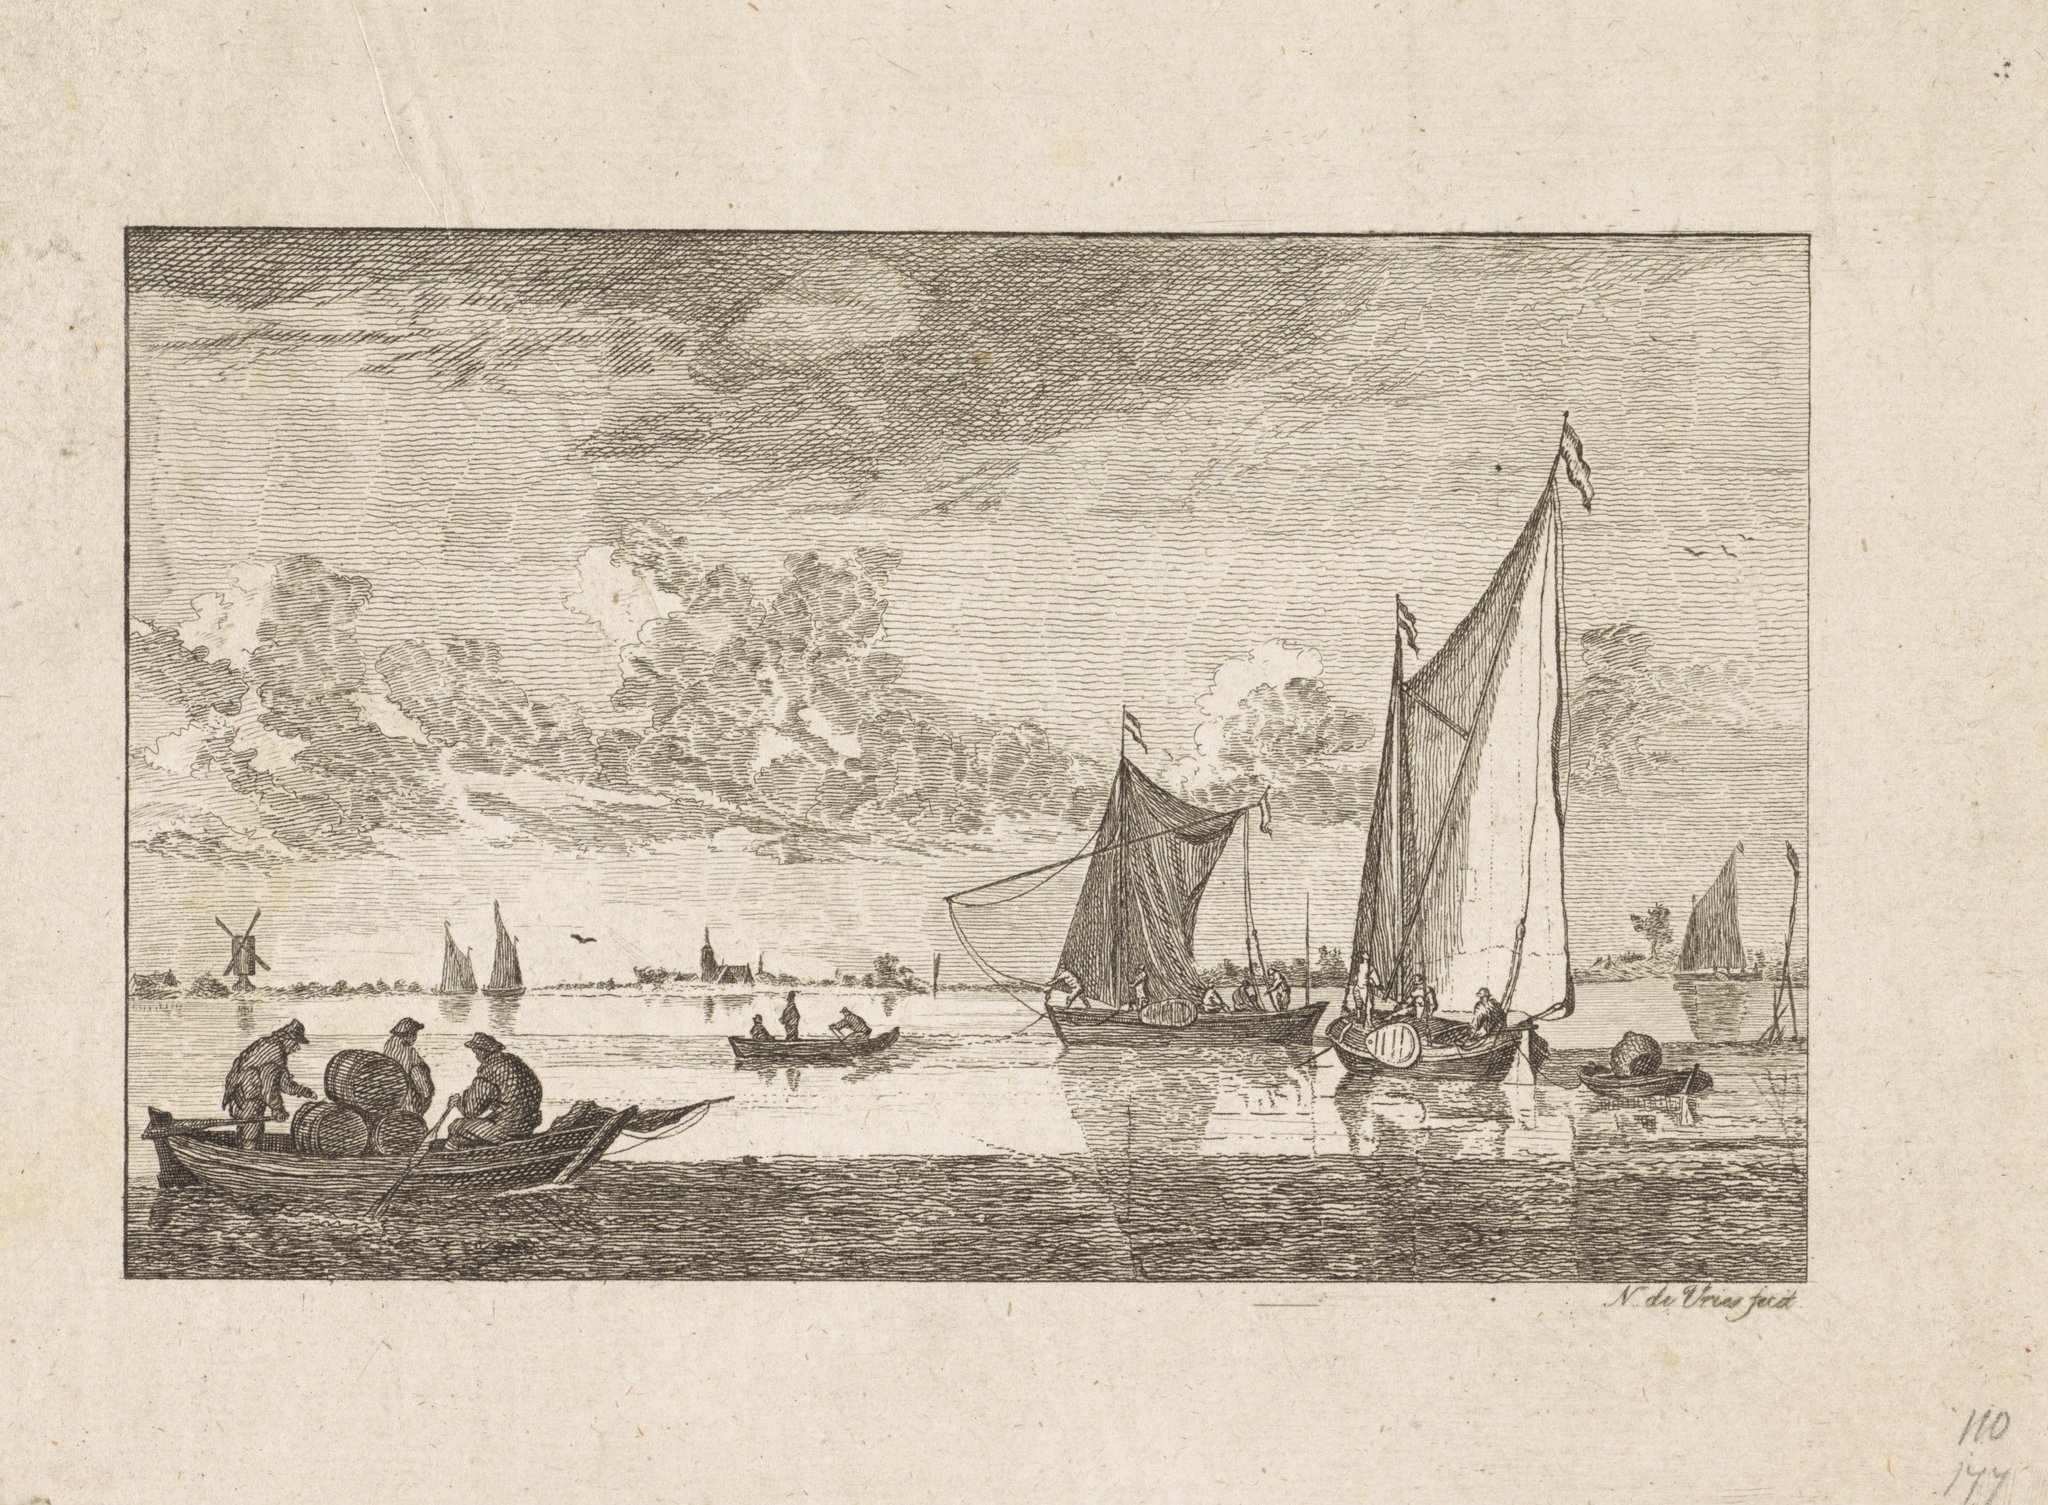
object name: print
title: Riviergezicht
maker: n. de vries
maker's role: print maker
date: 1800-1878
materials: paper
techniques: engraving, etching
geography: netherlands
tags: sailing-ship, sailing-boat, rowing-boat, canoe, etc., river (+ landscape with figures, staffage)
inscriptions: collector's mark: Lugt 2228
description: Riviergezicht met links een schuit waarin drie tonnen en drie personen. Op het water ook meerdere zeilschepen en sloepen.